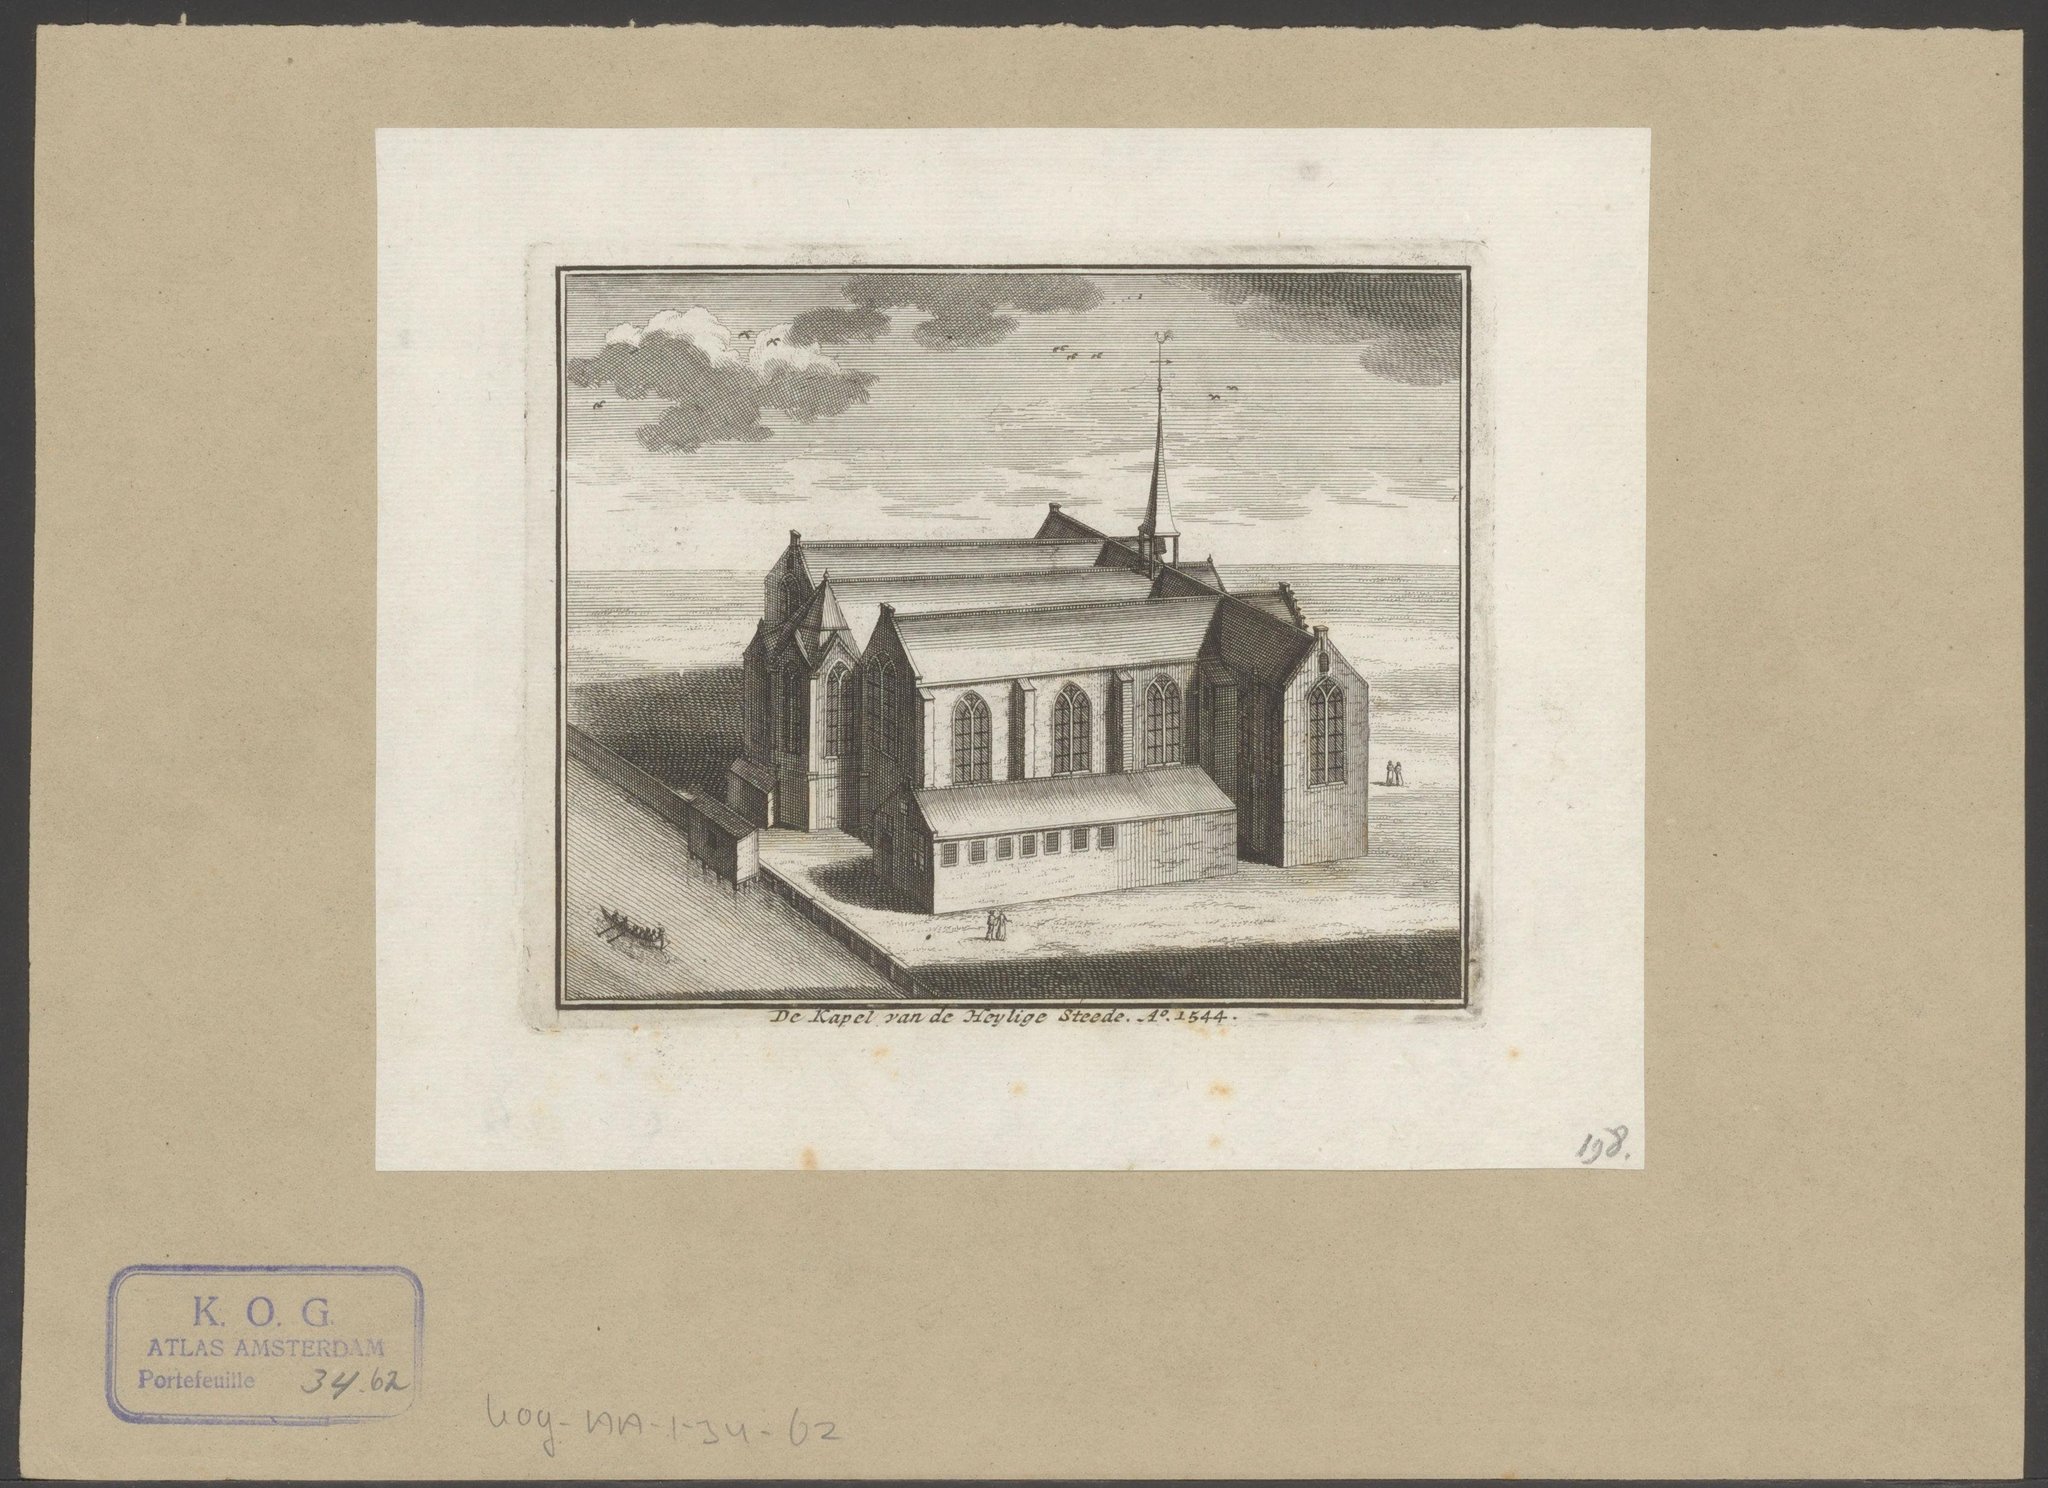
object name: print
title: Gezicht in vogelvlucht op de Heilige Stede te Amsterdam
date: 1729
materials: paper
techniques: engraving, etching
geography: amsterdam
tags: church (exterior) - qq - small church, chapel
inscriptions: collector's mark: Lugt 1641b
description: Prent mogelijk uit: Long, Isaac le. Historische beschryvinge van de reformatie der stadt Amsterdam (…). Amsterdam: Johannes van Septeren (I), 1729. Dat de prent de situatie rond 1544 weergeeft, gaat terug op het feit dat voor het maken van deze en andere prenten van kloosters en kerken van voor de Alteratie (1578) is uitgegaan van de plattegrond van Cornelis Anthonisz. uit 1544, zie RP-P-OB-70.399 en RP-P-AO-20-15.